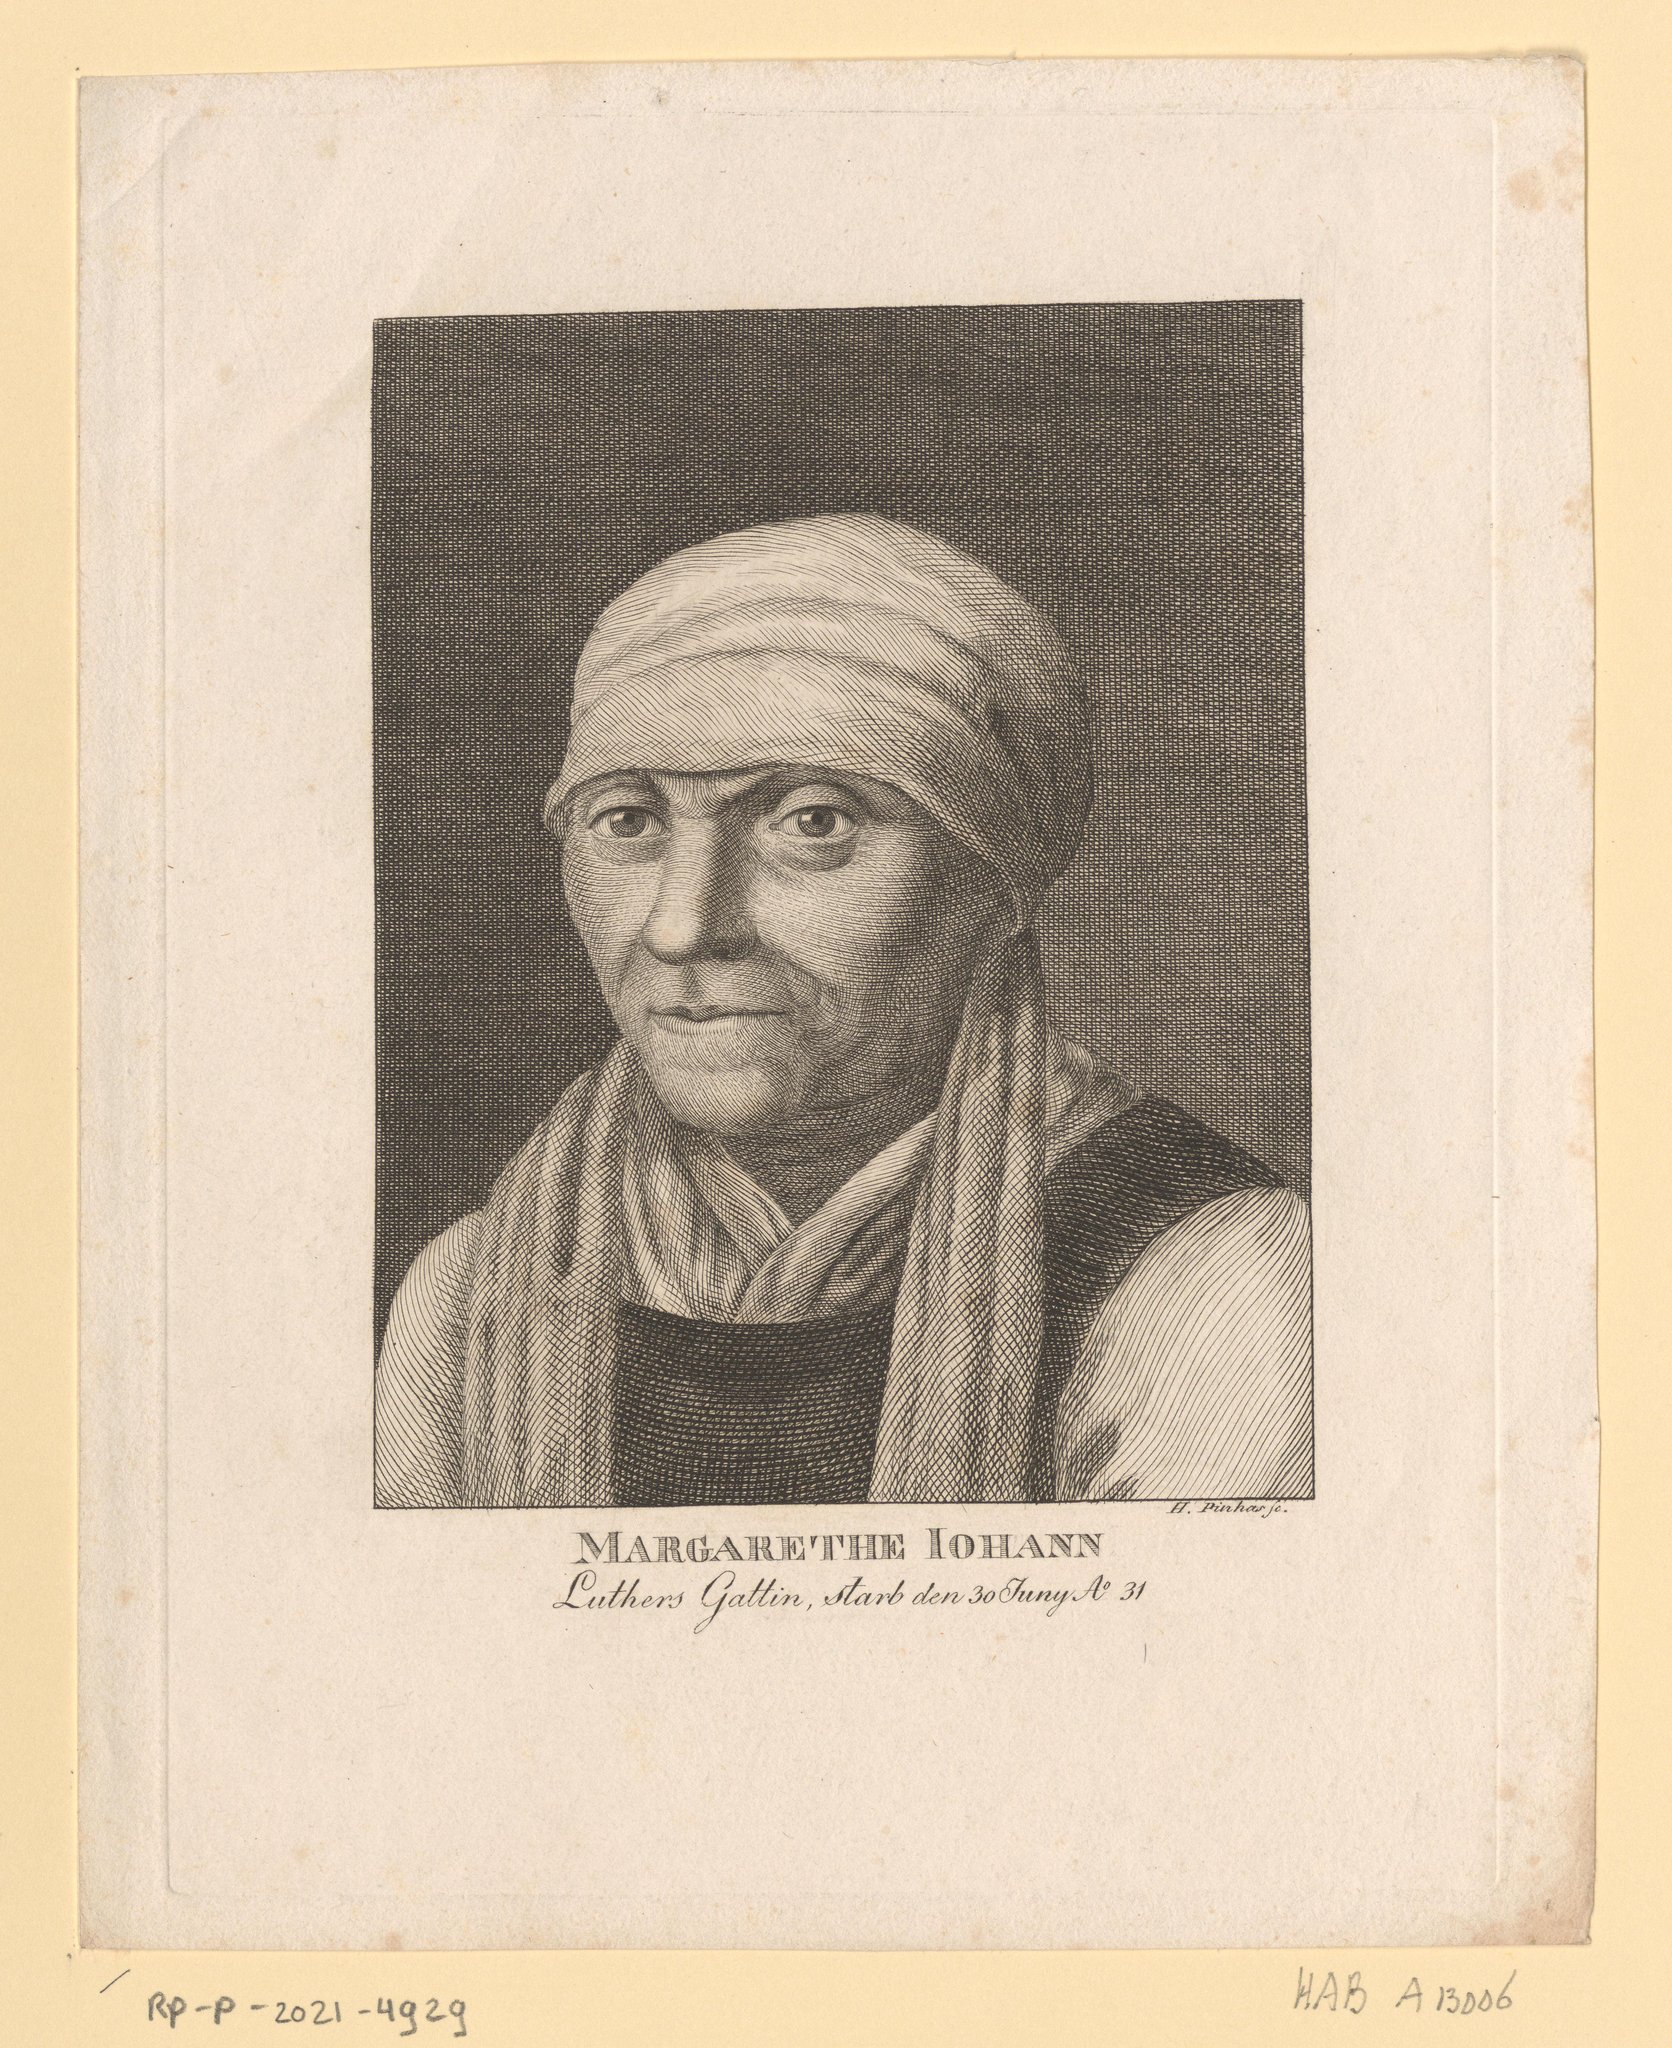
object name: print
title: Portret van Margarethe Luther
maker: hermann hirsch pinhas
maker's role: print maker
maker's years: 1795-1844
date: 1805-1844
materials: paper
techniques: engraving, etching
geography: germany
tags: historical persons - bb - woman